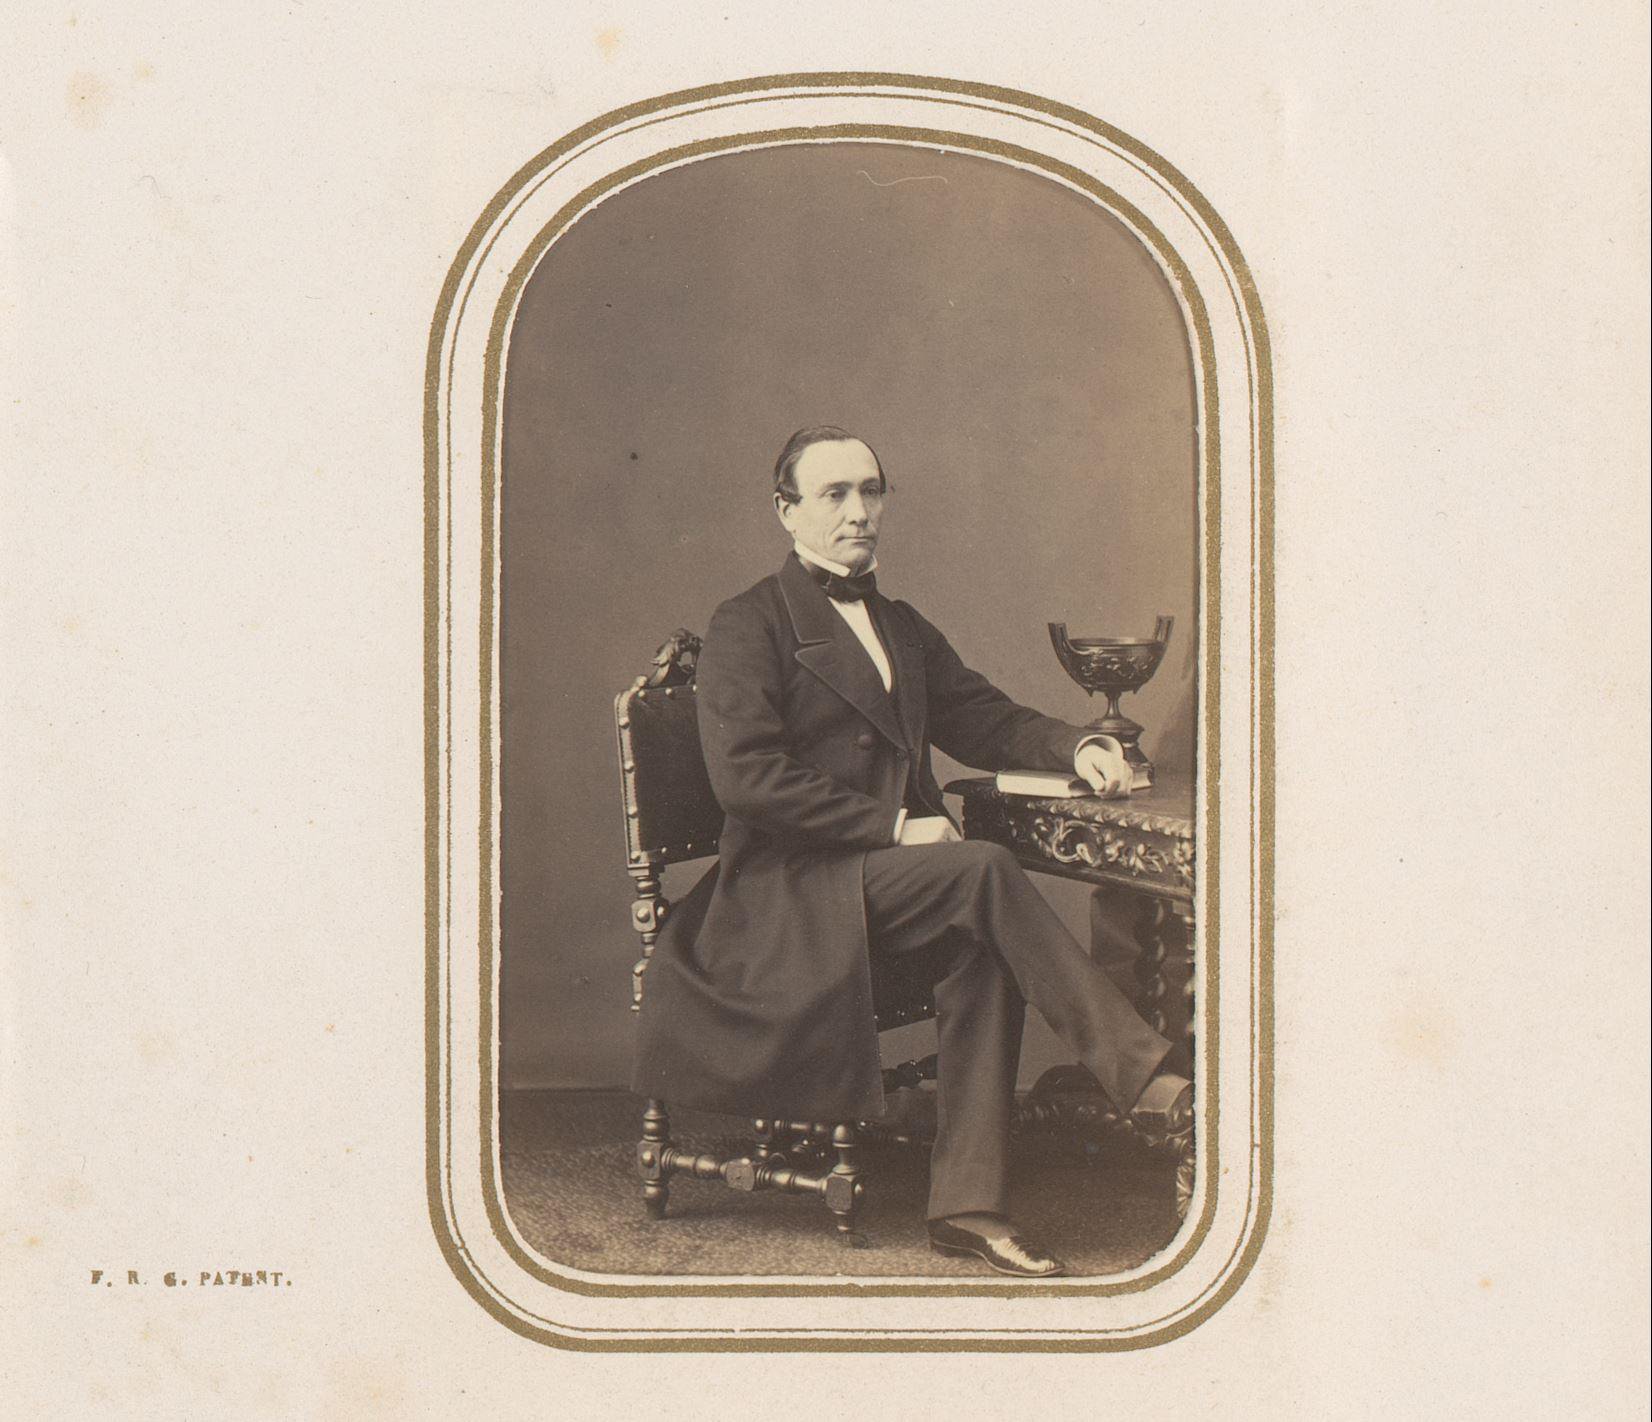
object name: carte de visite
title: Portret van een zittende man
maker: alexandre ken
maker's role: fotograaf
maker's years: 1828-1874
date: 1850-1874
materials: cardboard, photographic support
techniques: albumen print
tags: sitting figure, adult man, historical persons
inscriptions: inscription: ‘A. Ken/ Photogrpahe/ Boulevt Montmartre 10/ Paris’